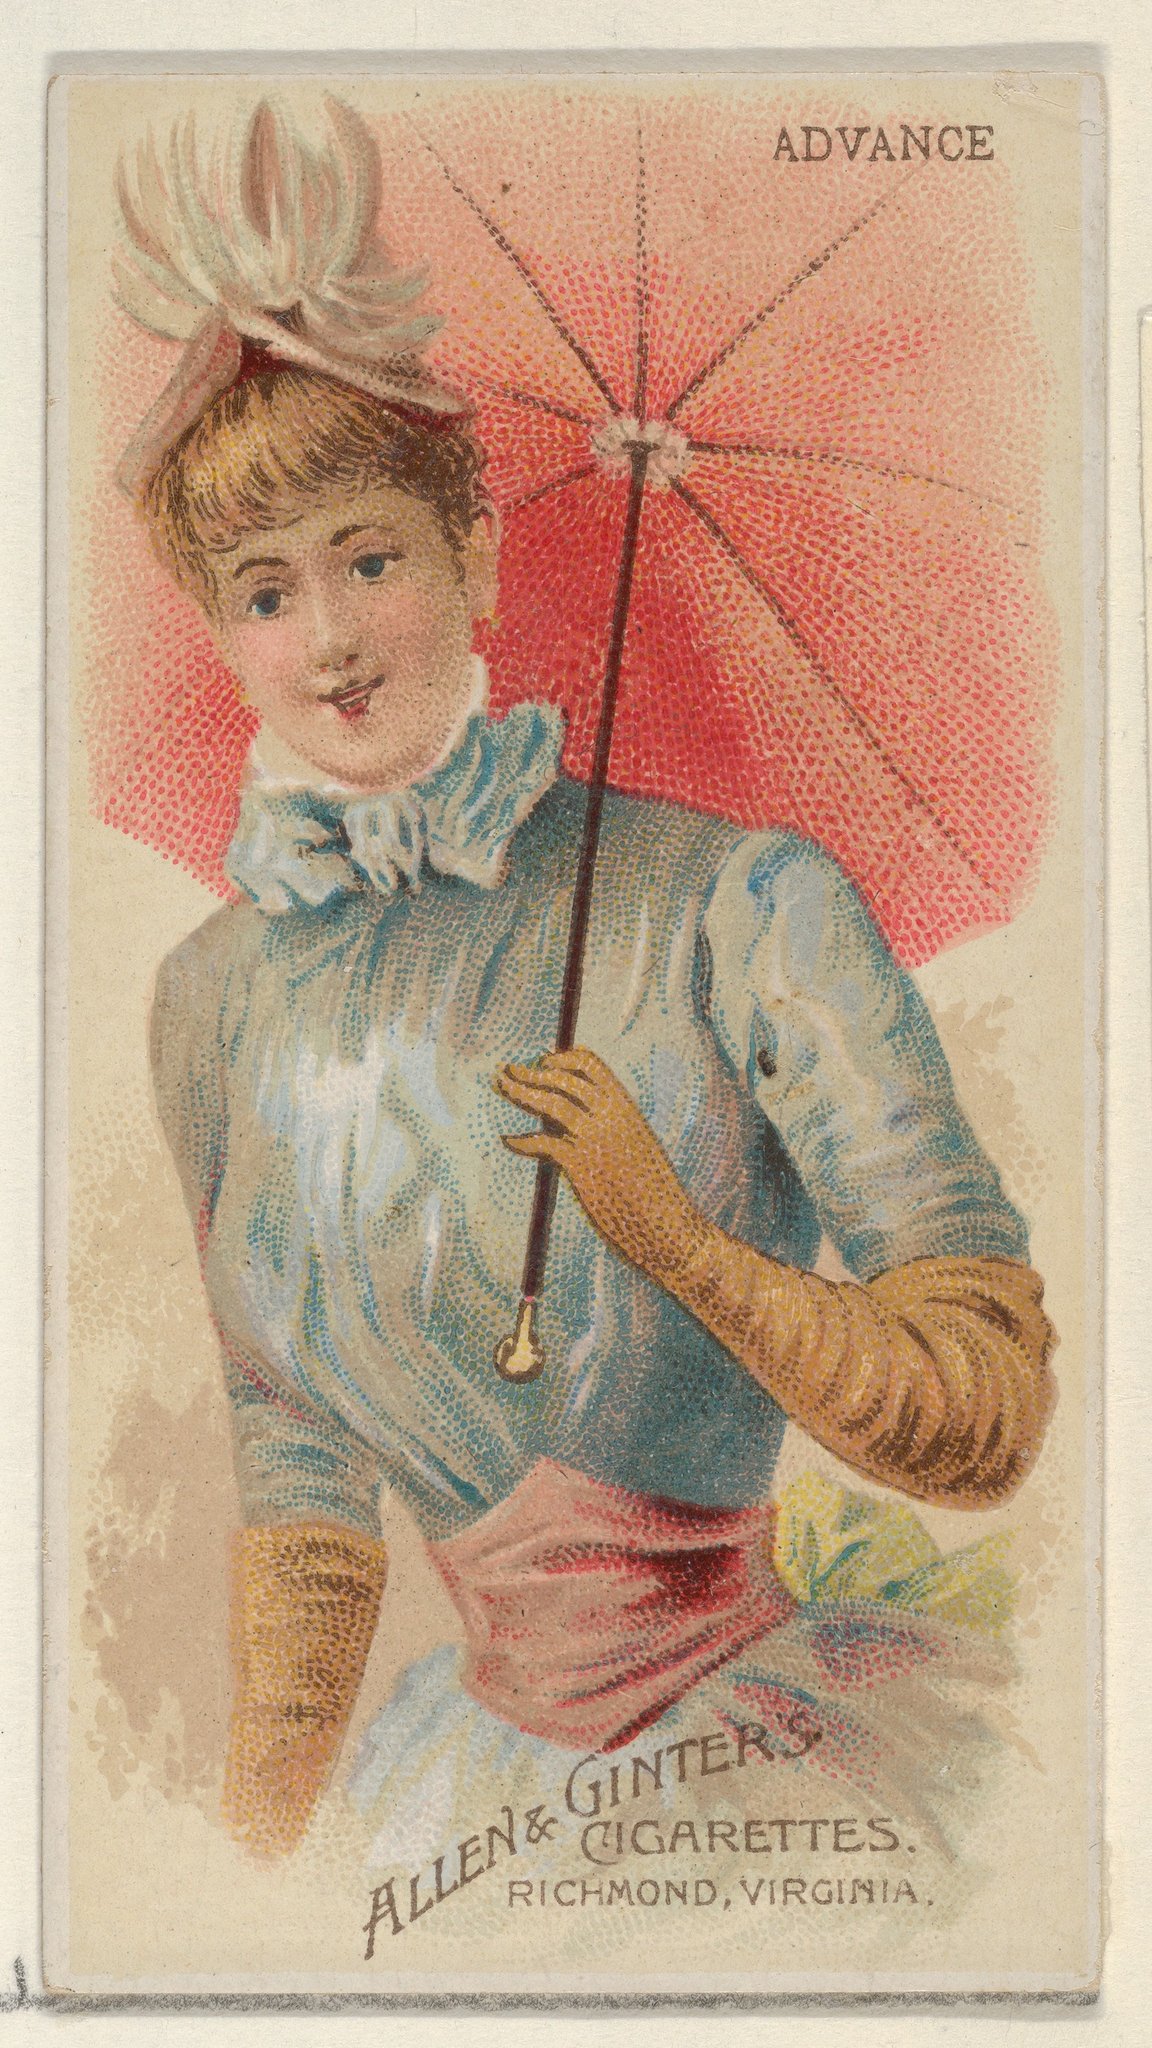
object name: print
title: Advance, from the Parasol Drills series (N18) for Allen & Ginter Cigarettes Brands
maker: allen & ginter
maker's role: publisher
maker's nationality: american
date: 1888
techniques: color lithograph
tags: women